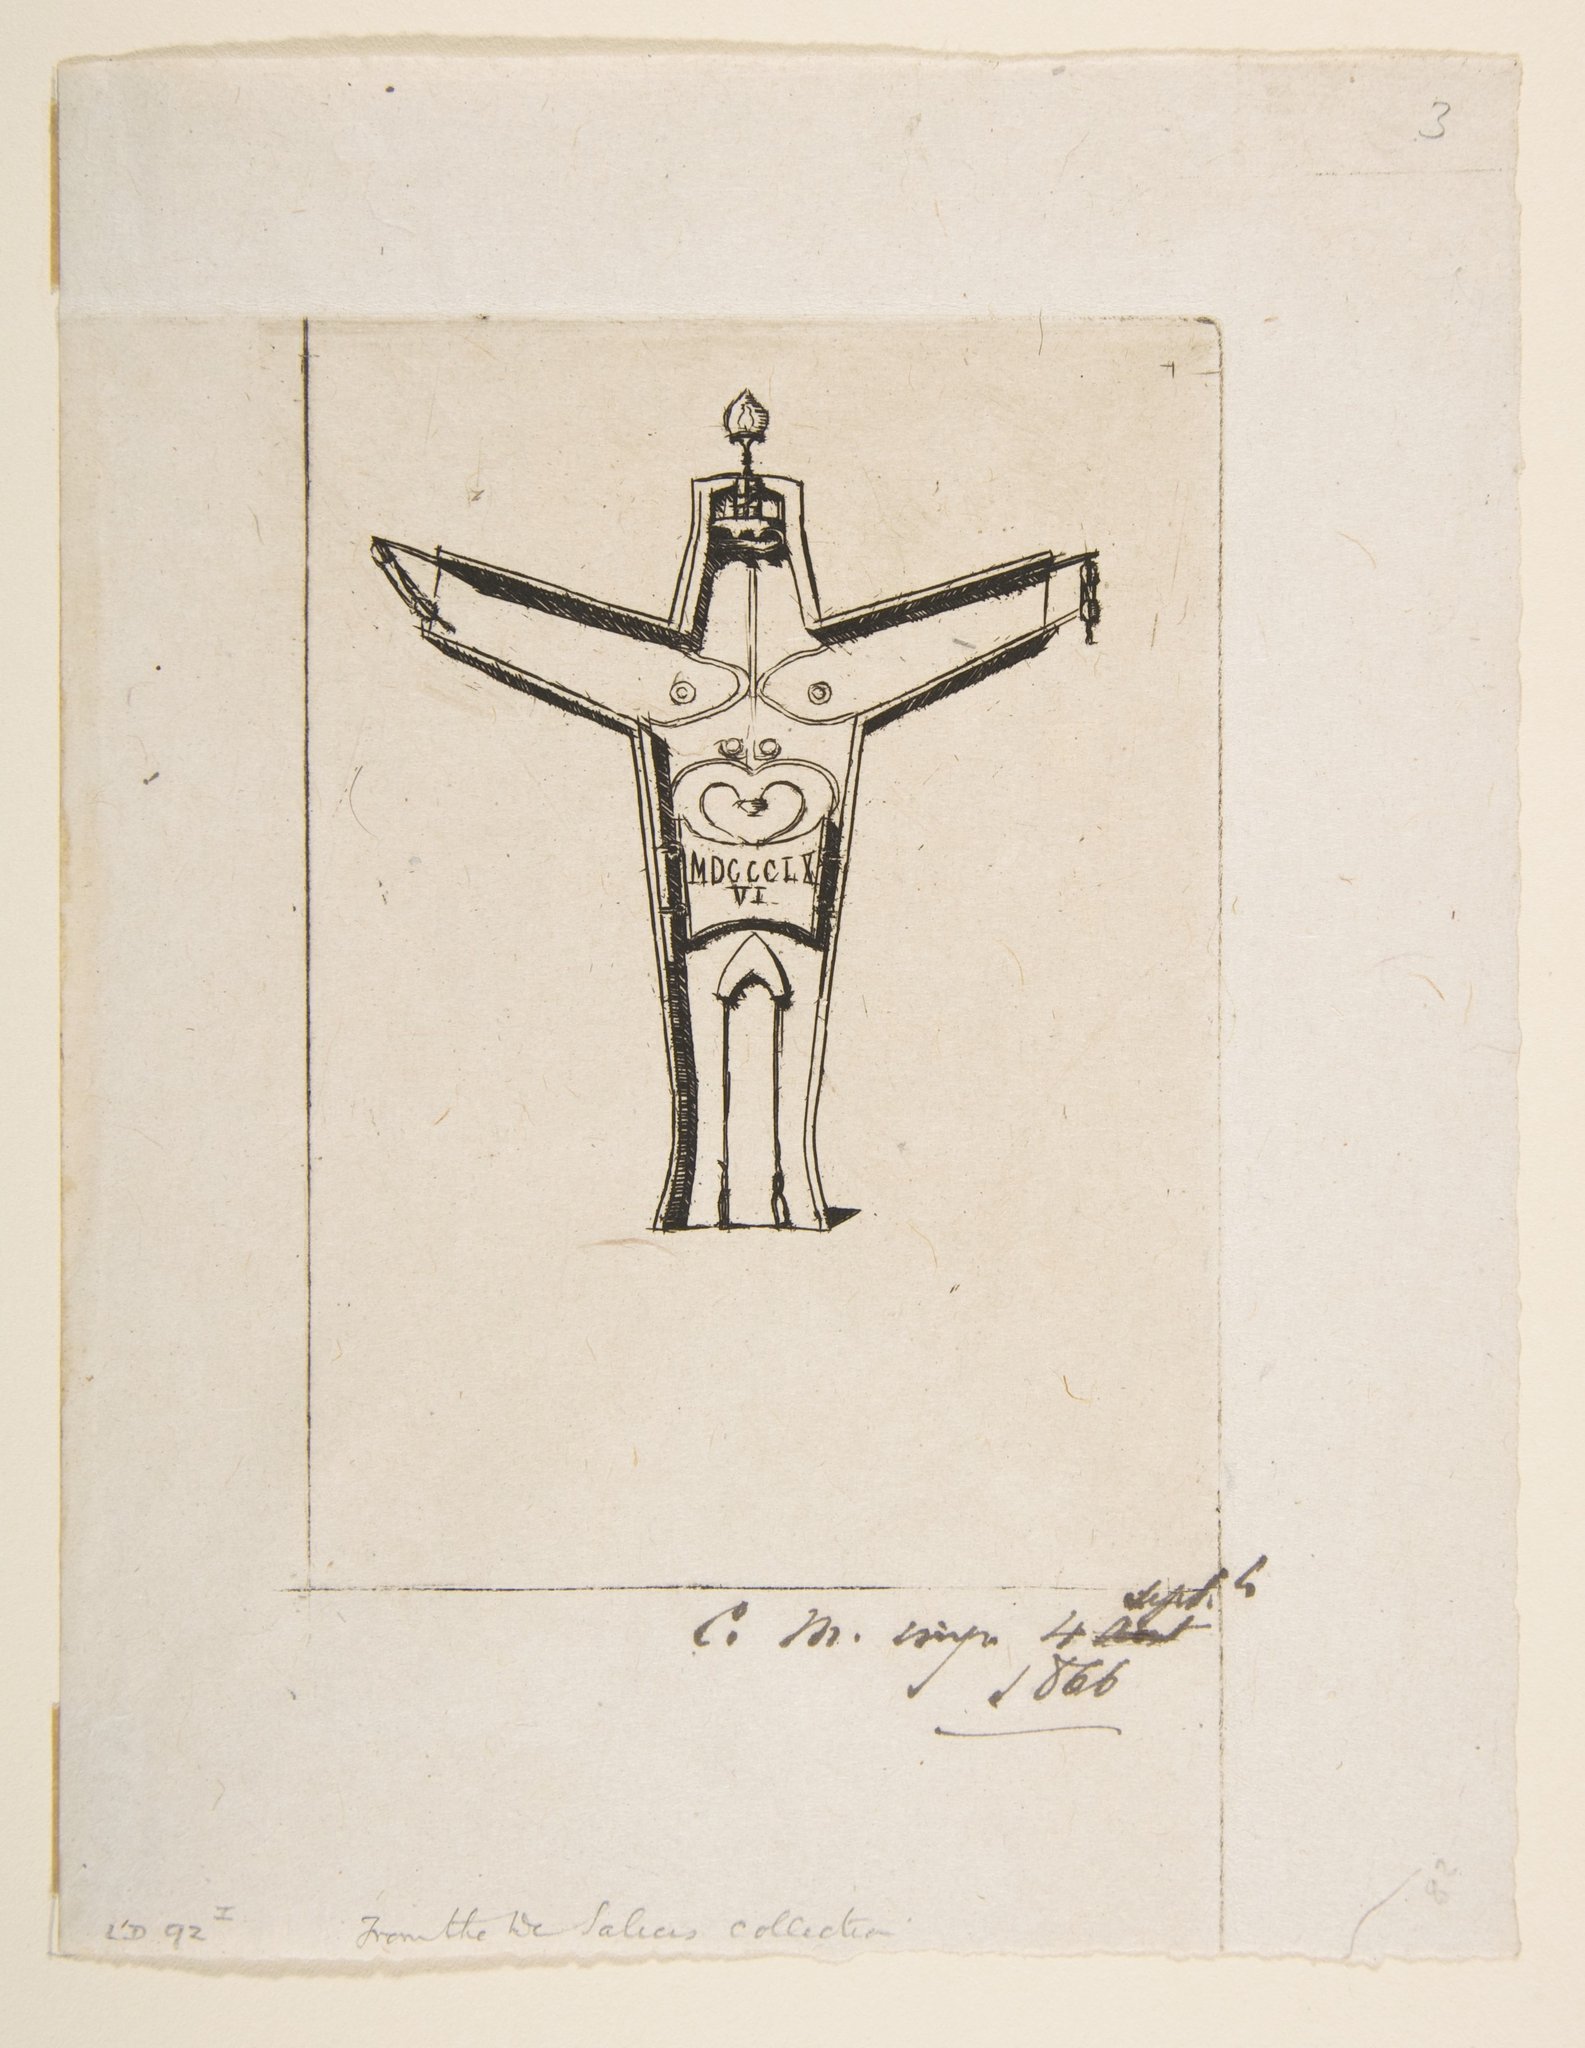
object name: print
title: Lunar Law, No 2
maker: charles meryon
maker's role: artist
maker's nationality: french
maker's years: 1821-1868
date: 1866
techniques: etching